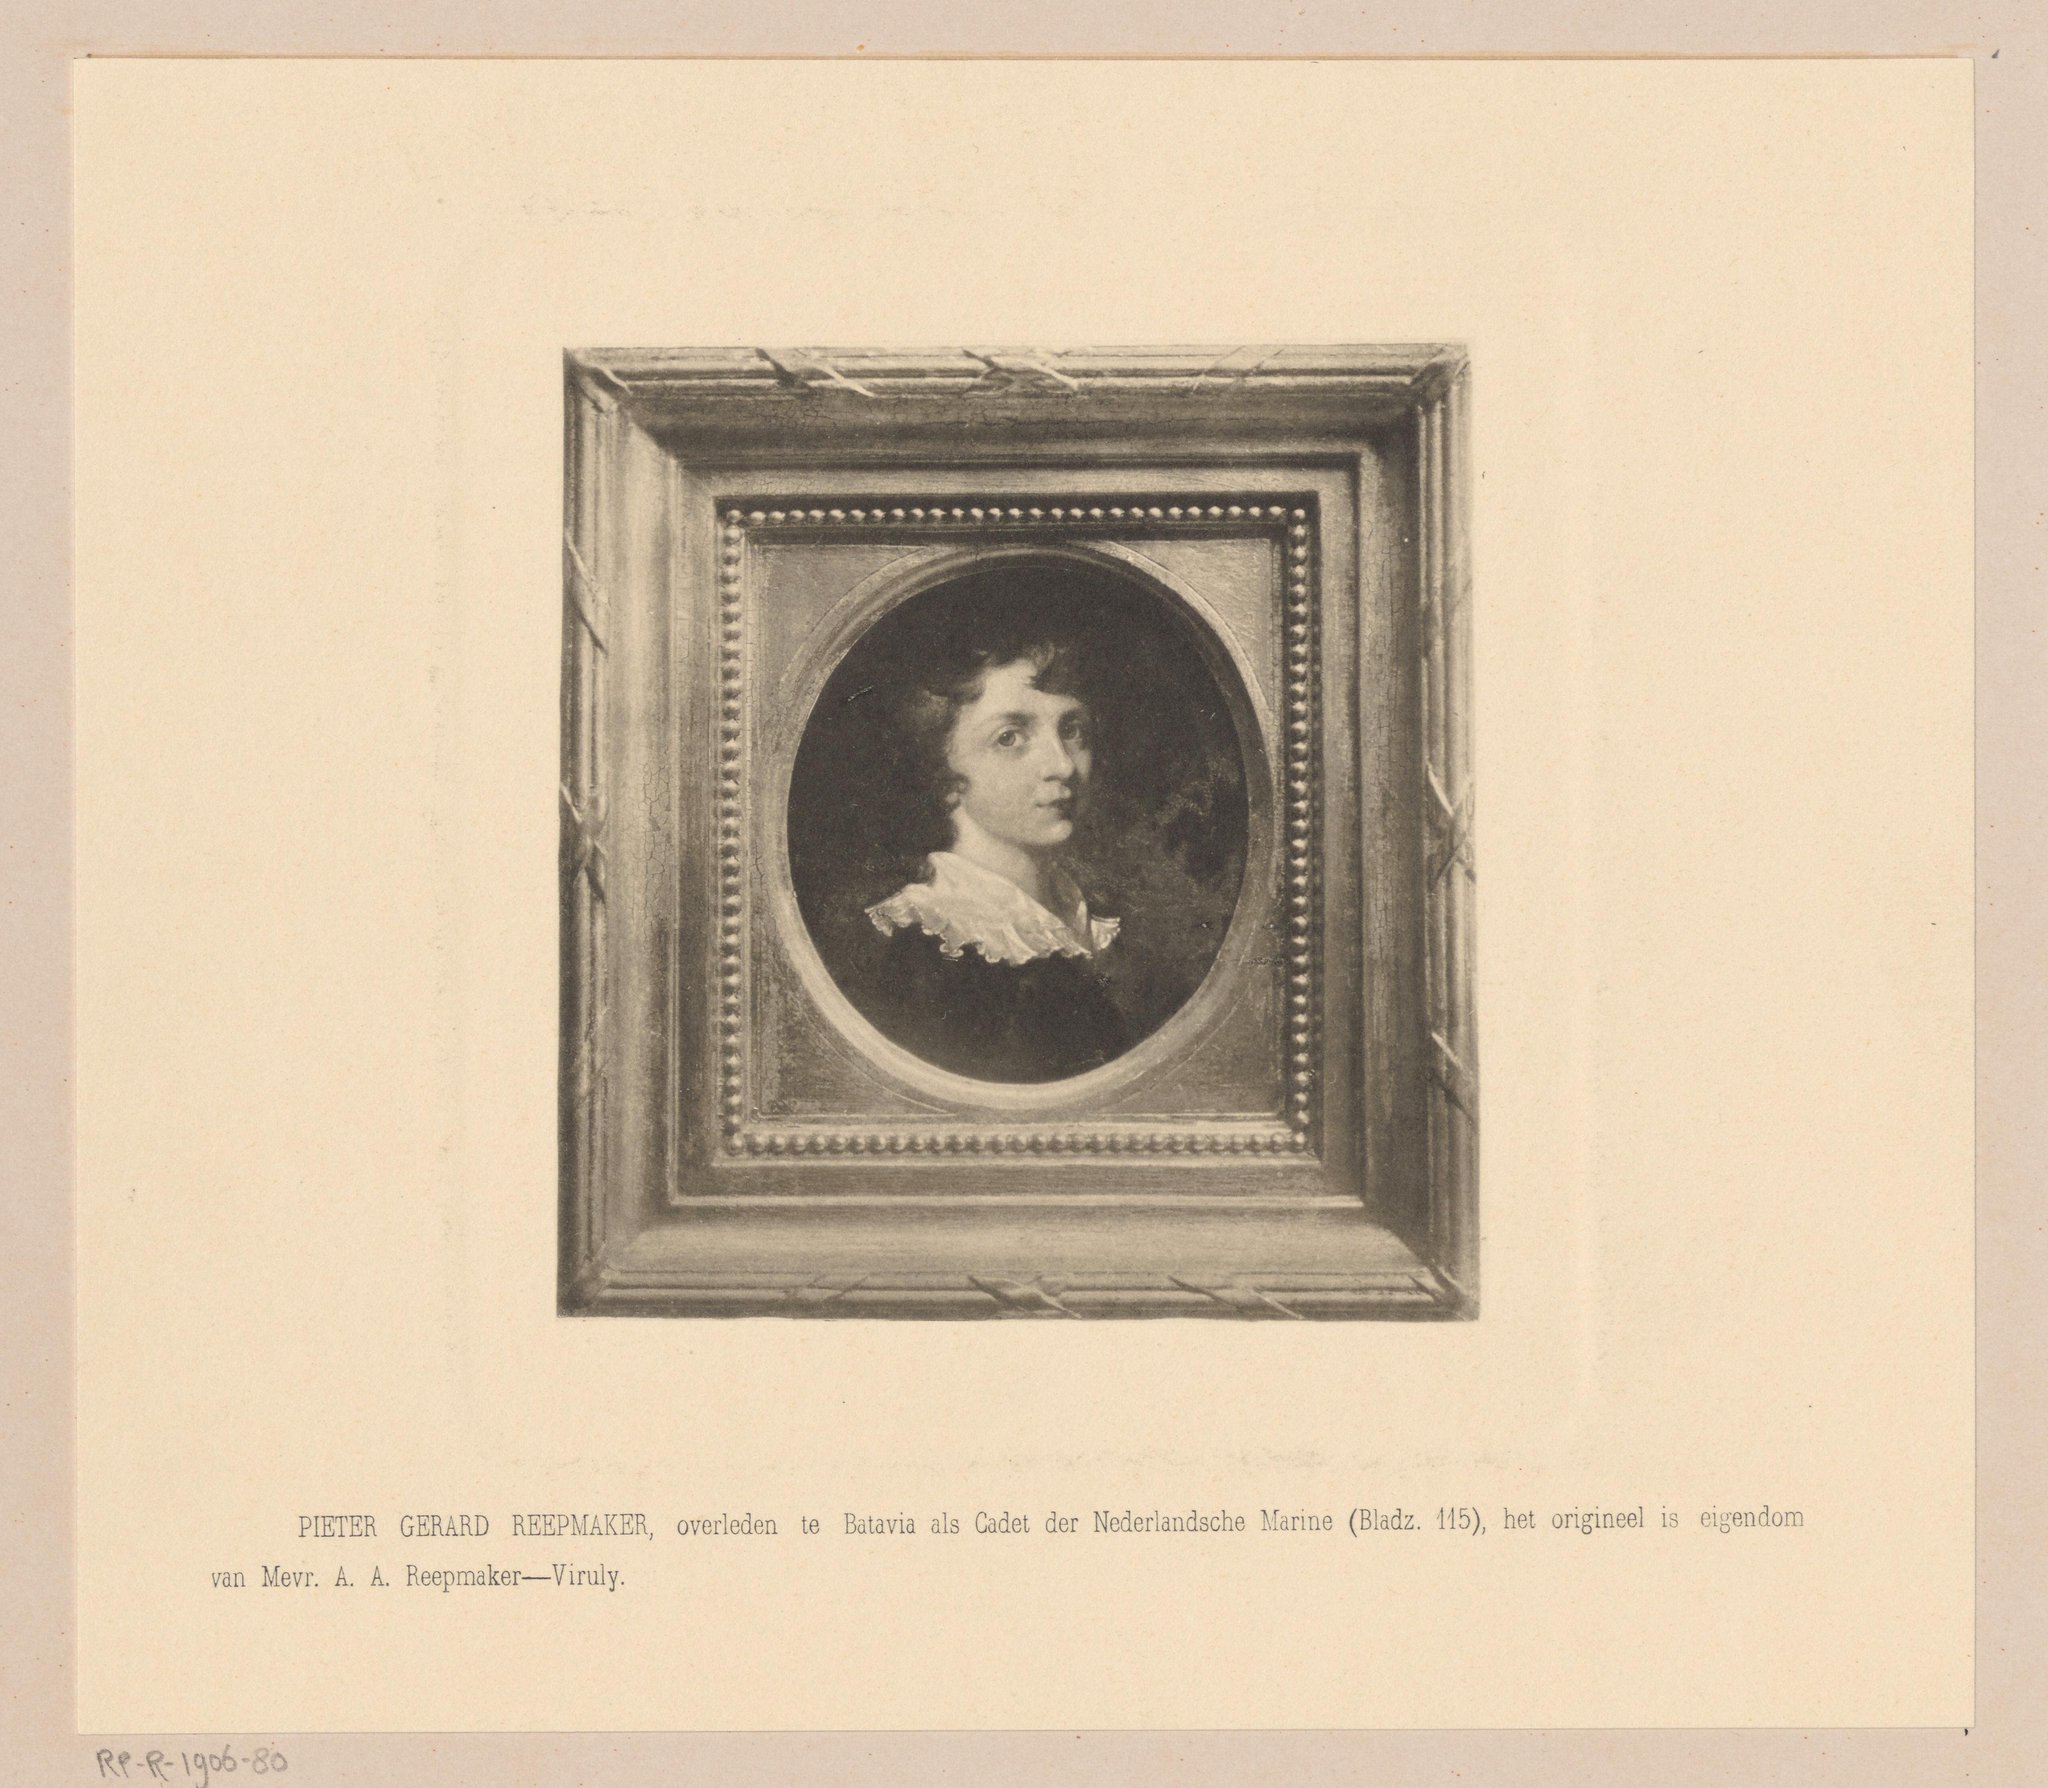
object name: photomechanical print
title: Portret van Pieter Gerard Reepmaker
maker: Anonymous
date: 1875-1906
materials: paper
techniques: photograph, letterpress printing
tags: rotterdam, historical persons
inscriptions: collector's mark: Lugt 2228